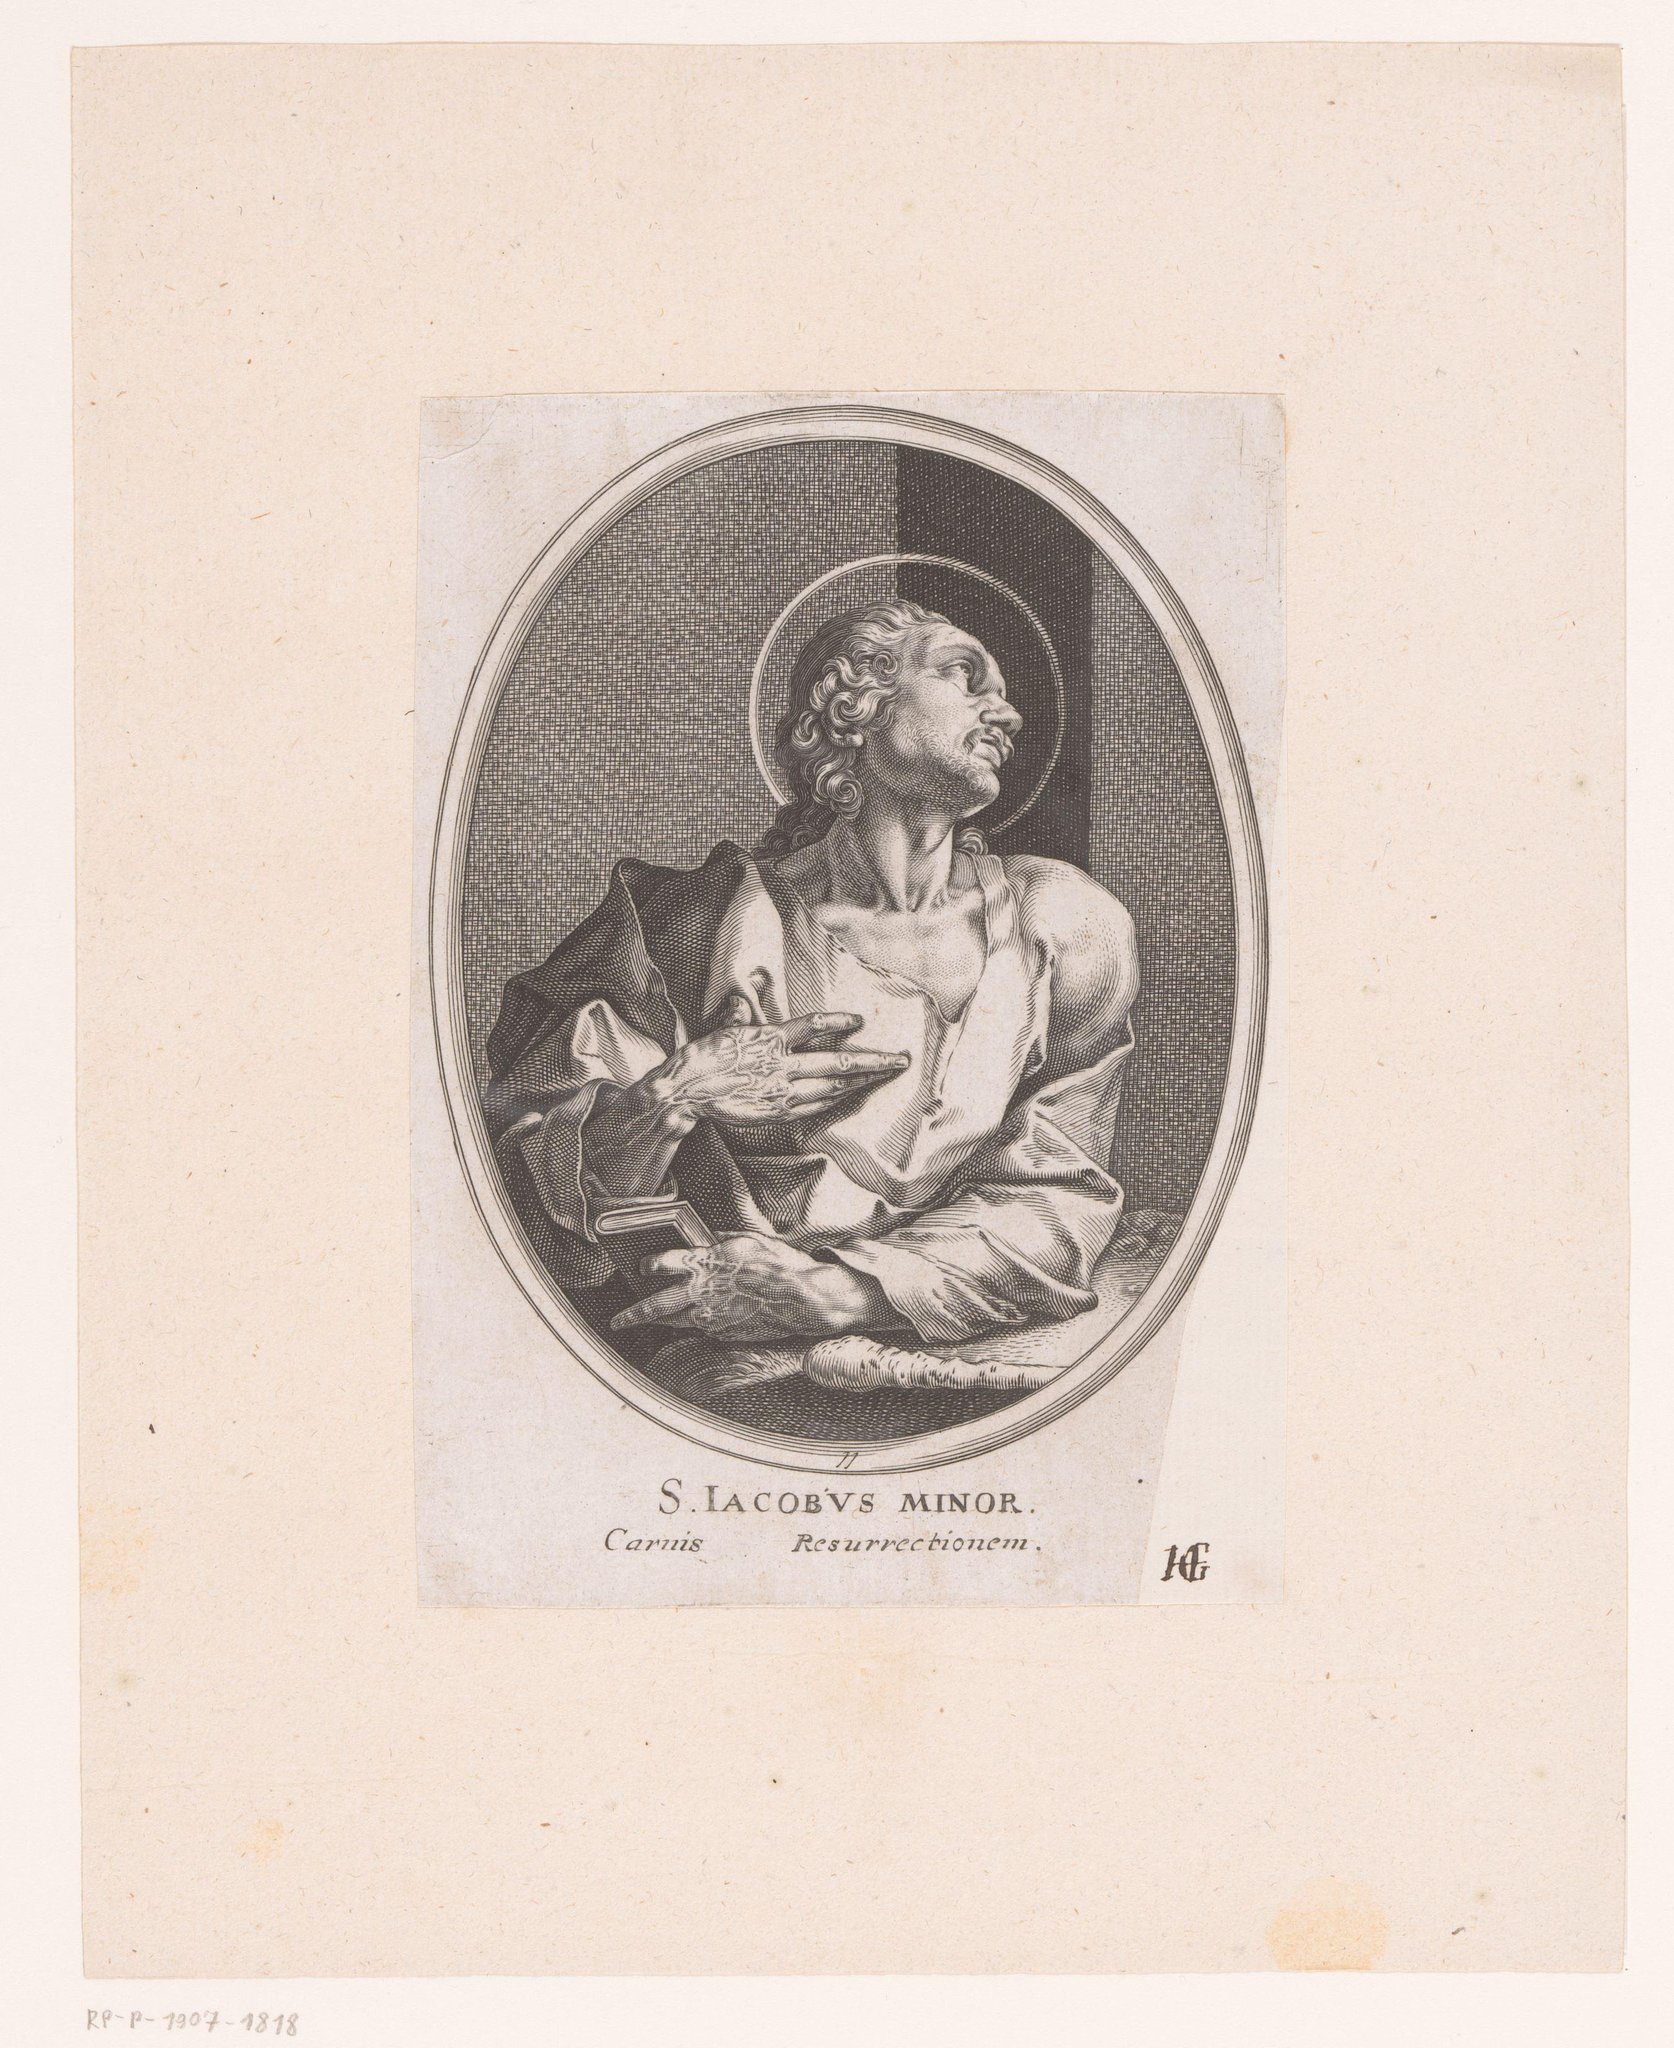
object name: print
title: S. Jacobus Minor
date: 1610-1668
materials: paper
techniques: engraving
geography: paris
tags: the apostle james the less, first bishop of jerusalem; possible attributes: book, fuller's club, scroll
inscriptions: monogram: ‘HG’, collector's mark: Lugt 2228